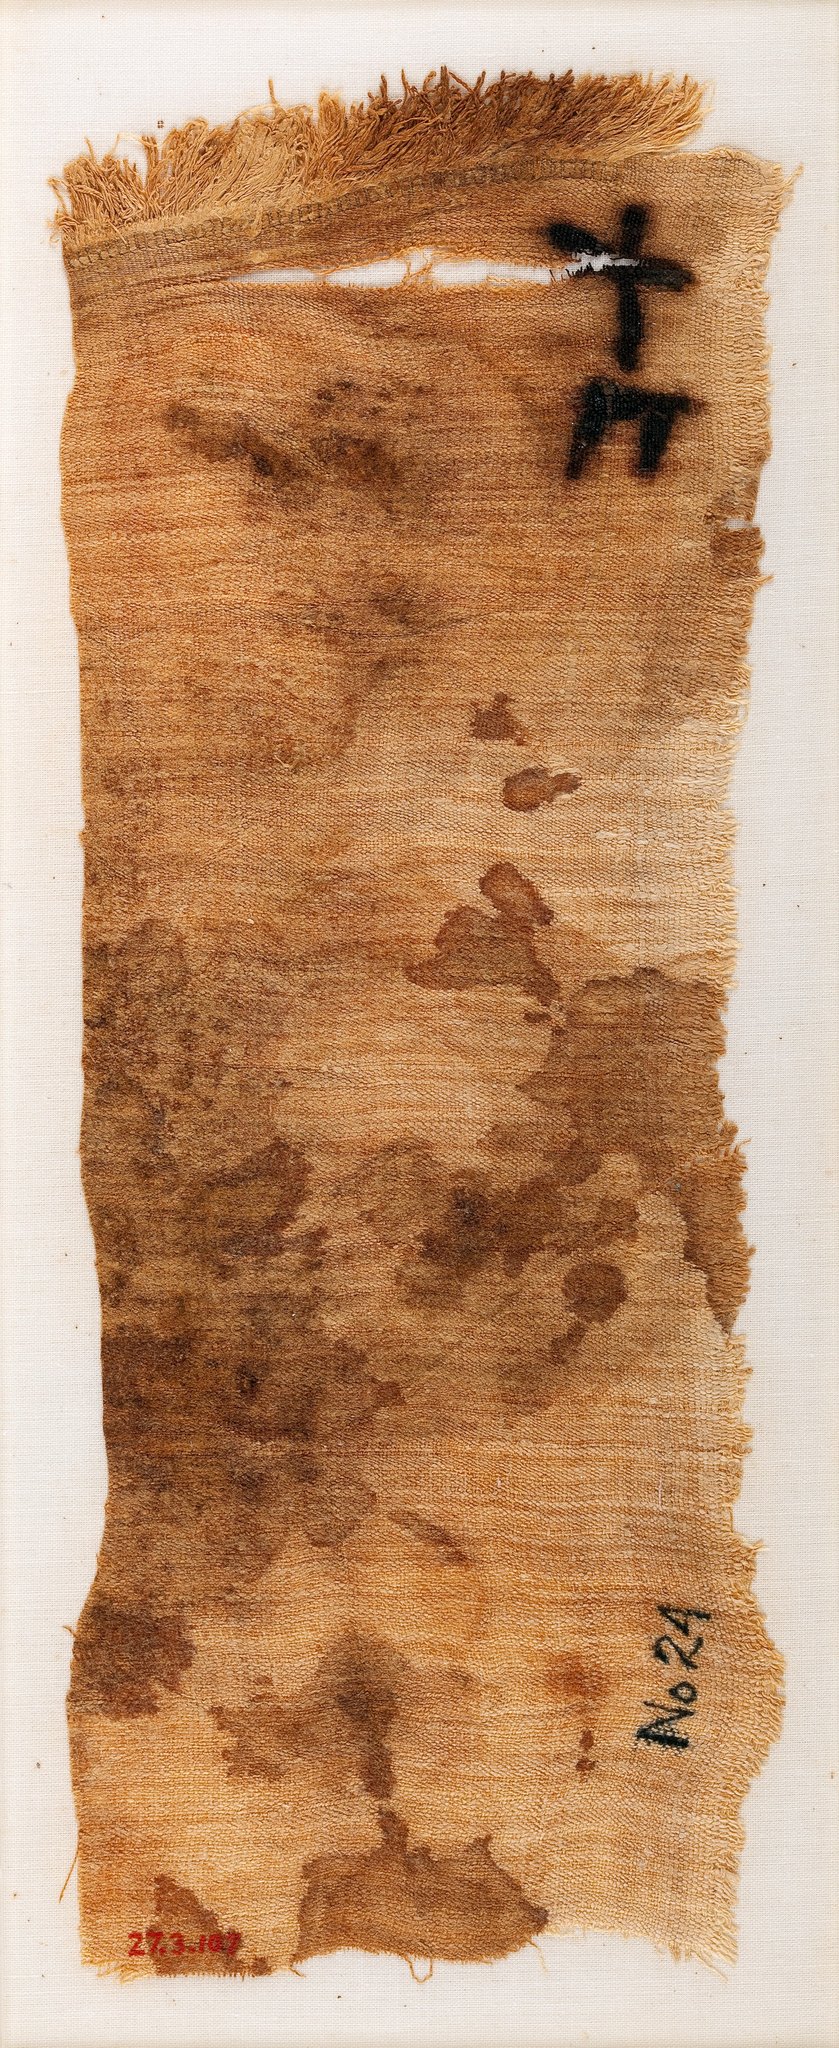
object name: linen mark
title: Linen mark (Type XI)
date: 1961-1917 BCE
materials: linen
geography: egypt